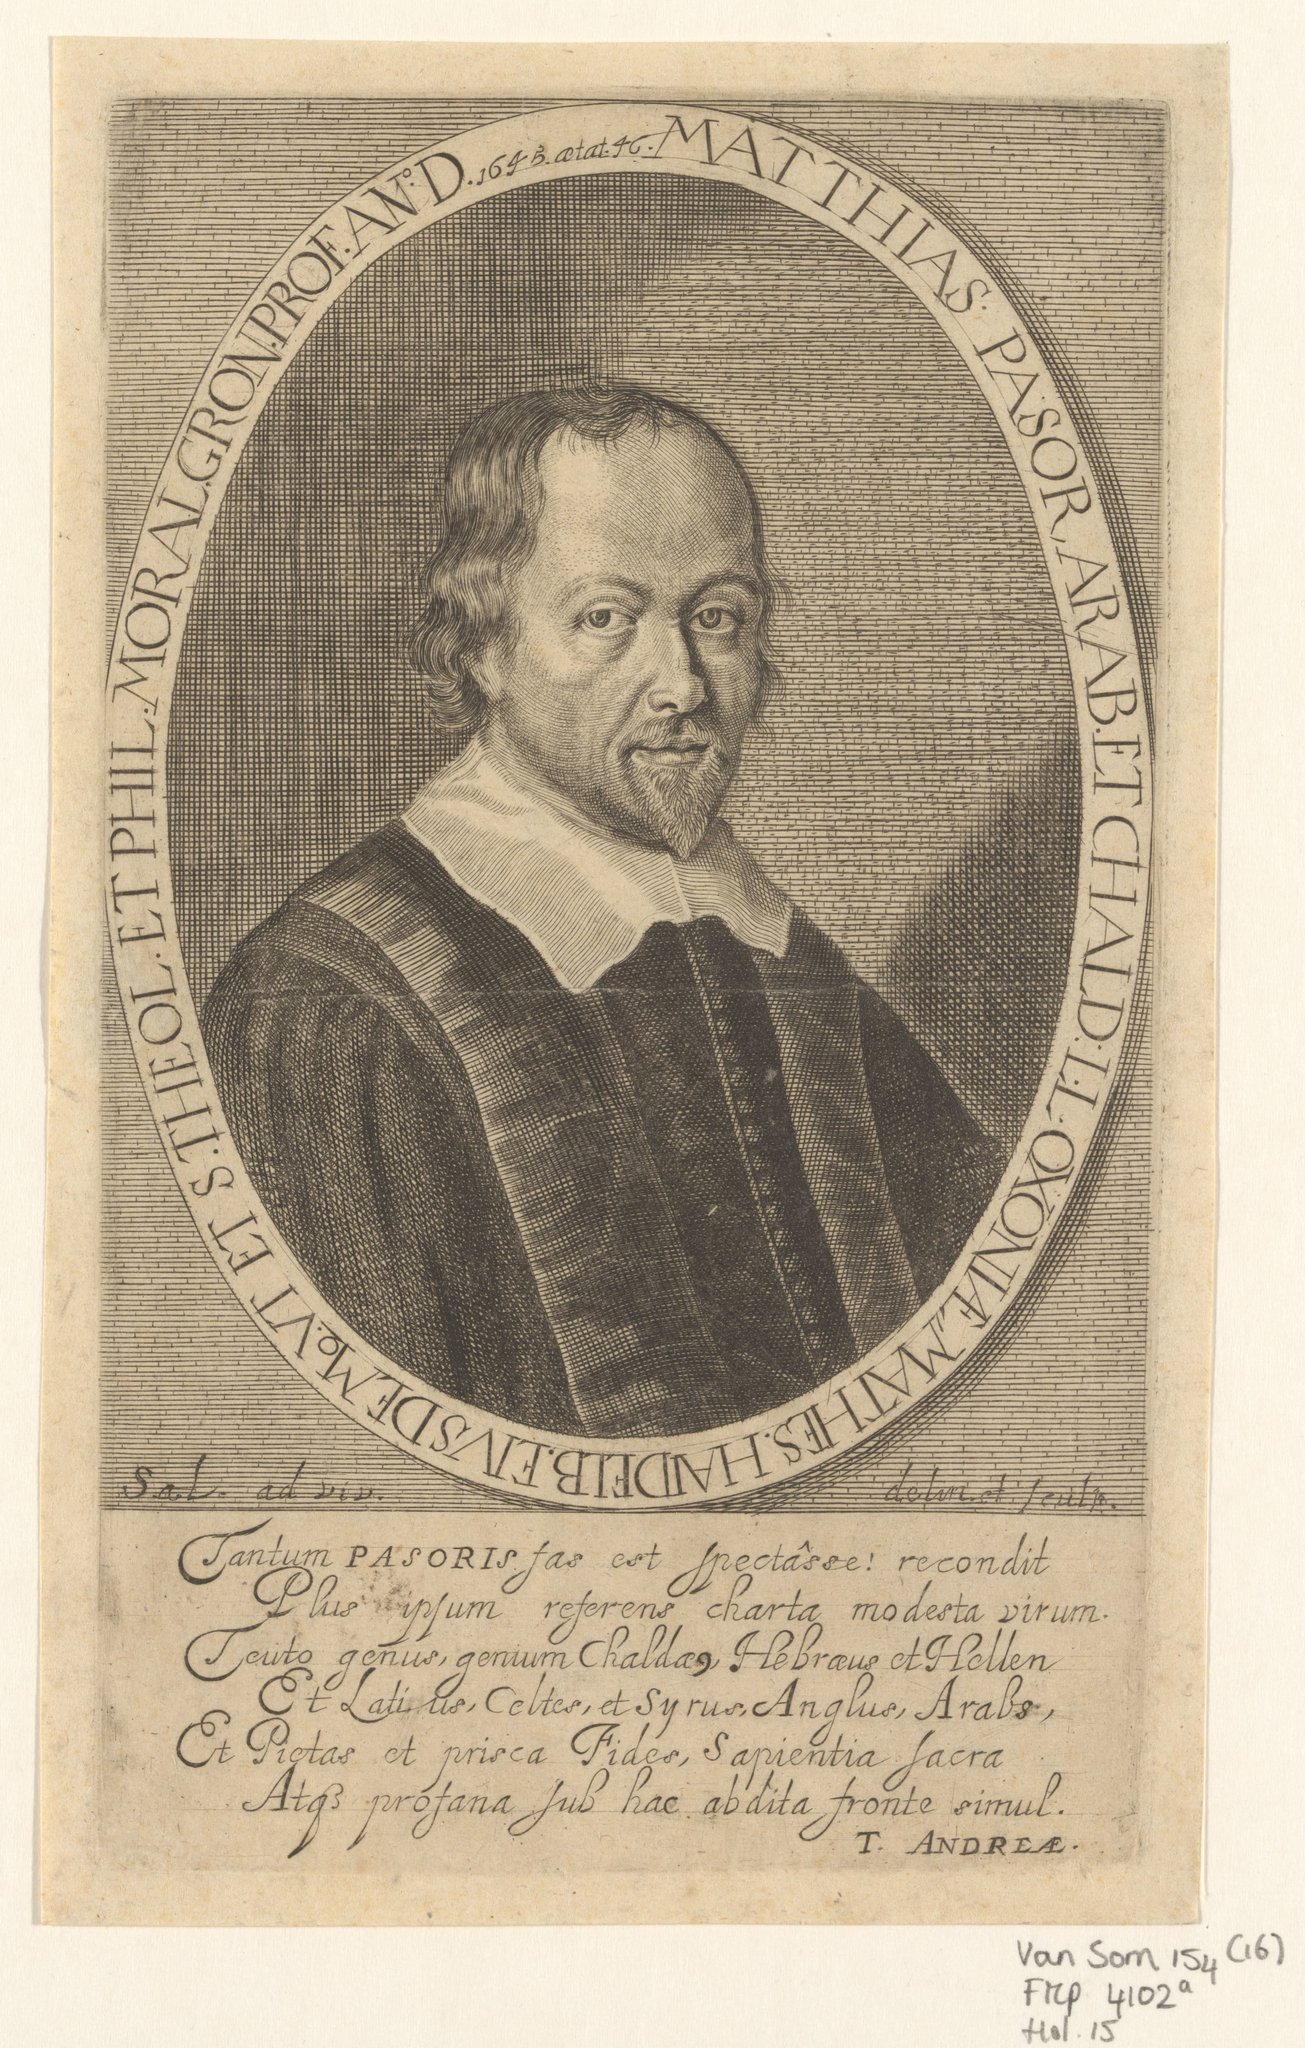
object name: print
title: Portret van Matthias Pasor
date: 1654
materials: paper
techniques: engraving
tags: matthias pasor, historical persons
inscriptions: collector's mark: Lugt 2228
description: Portretbuste in ovaal naar rechts van Matthias Pasor, hoogleraar in de theologie te Groningen, blootshoofds. Op de ovale omlijsting staat een randschrift in Latijn, in de marge een zesregelig Latijns vers.